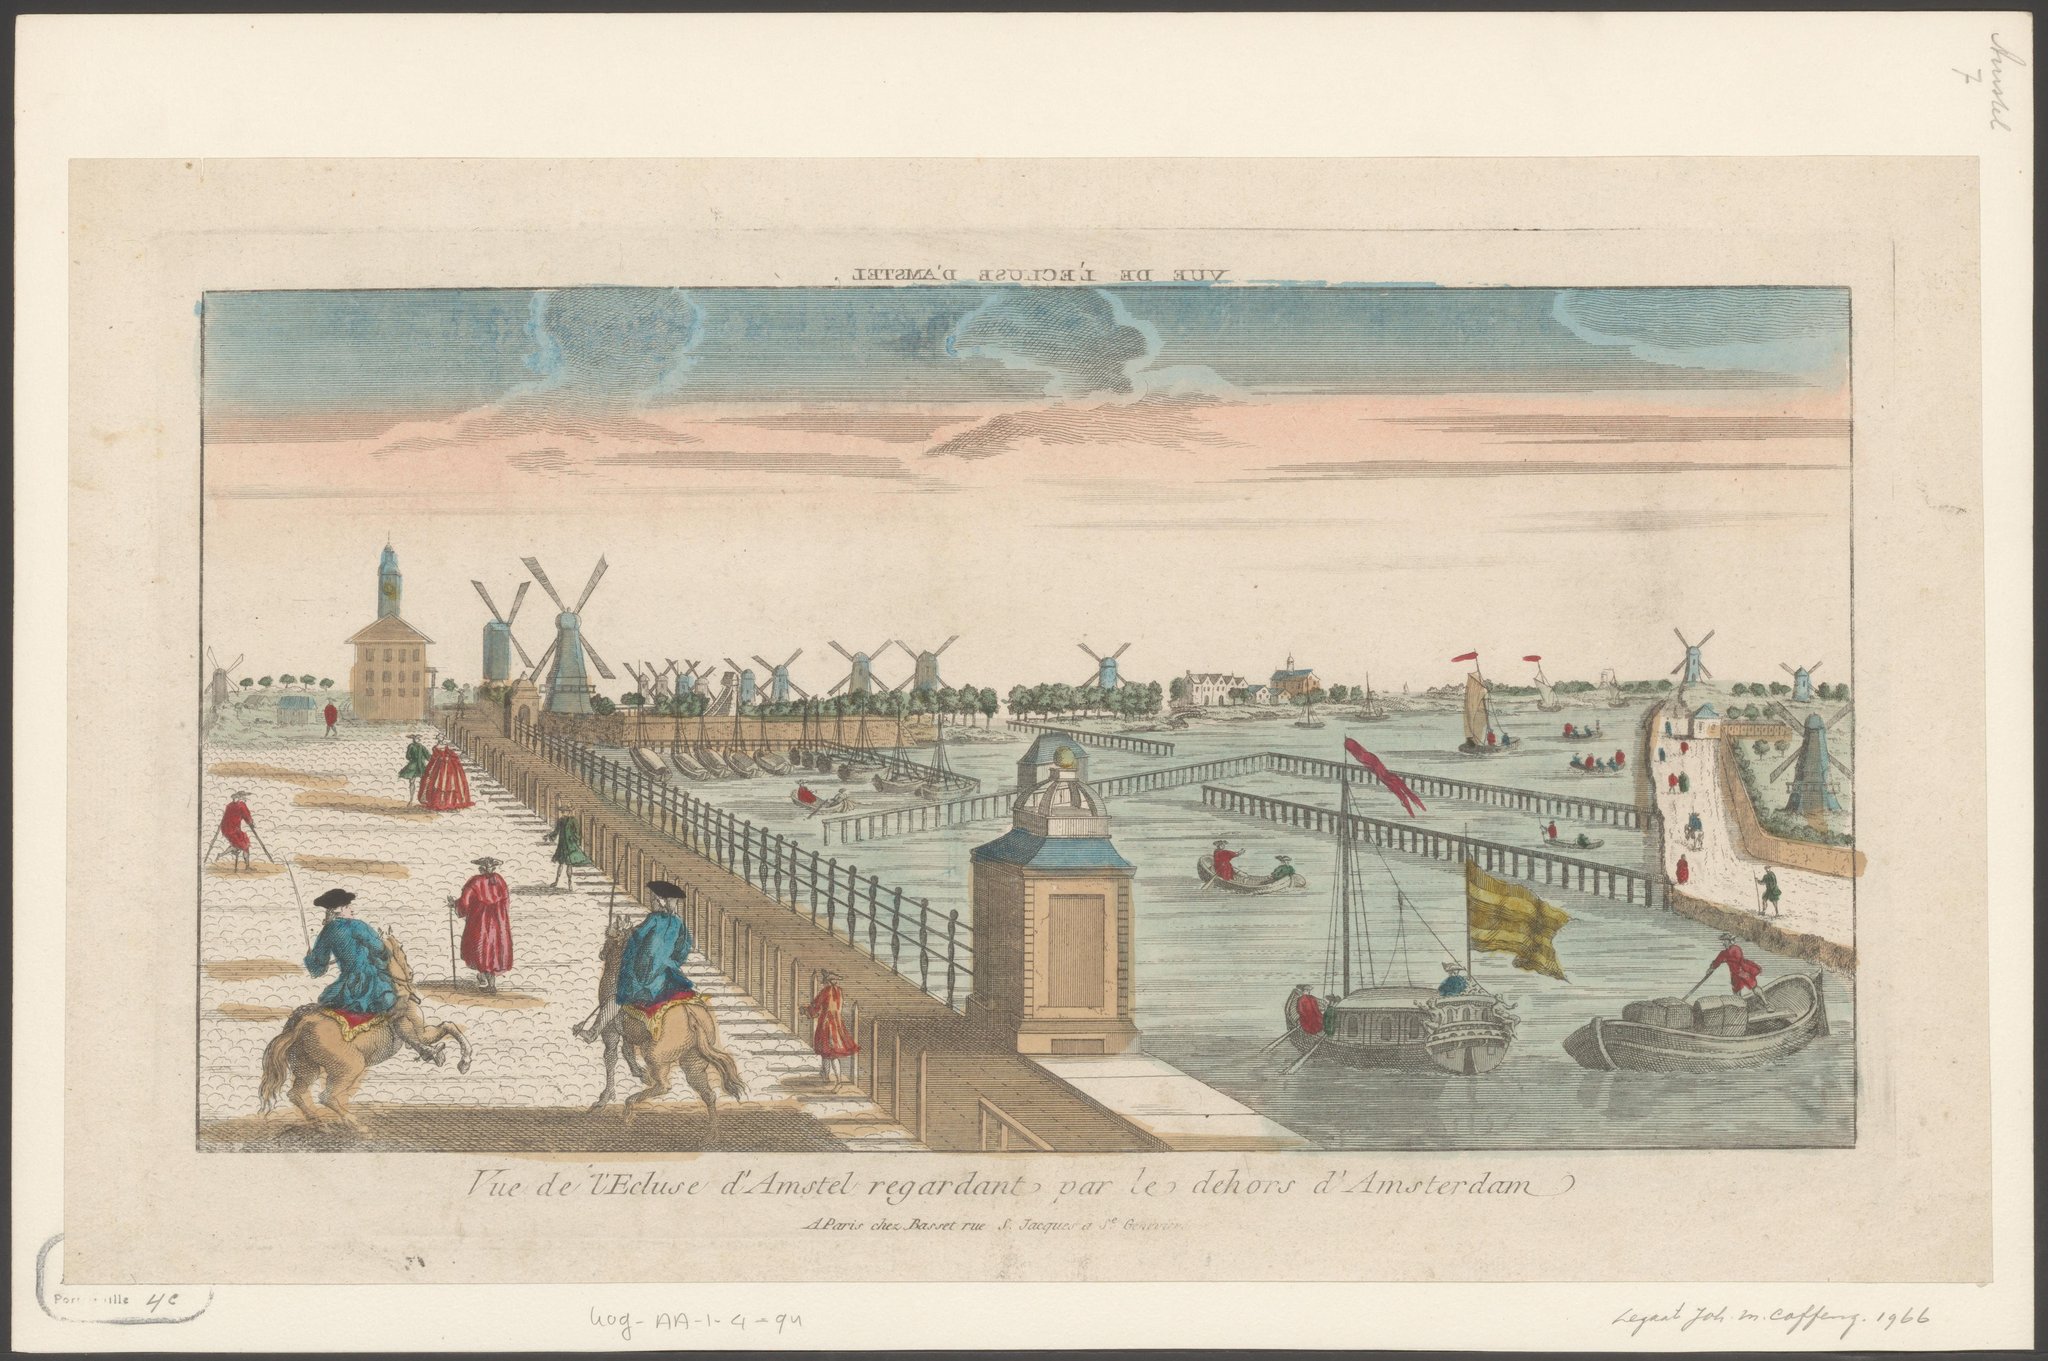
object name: print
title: Gezicht op de Binnen-Amstel en de Hogesluis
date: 1750-1865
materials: paper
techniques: etching, hand coloring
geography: france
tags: city-view in general; 'veduta', river, windmill in landscape, bridge in city across river, canal, etc.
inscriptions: collector's mark: ‘4C’ Lugt 1641b, inscription: ‘Legaat Joh. M. Coffeng. 1966’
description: Onderwerpsrubriek binnen de Atlas Amsterdam: Amstel van Hogesluis stroomopwaarts.